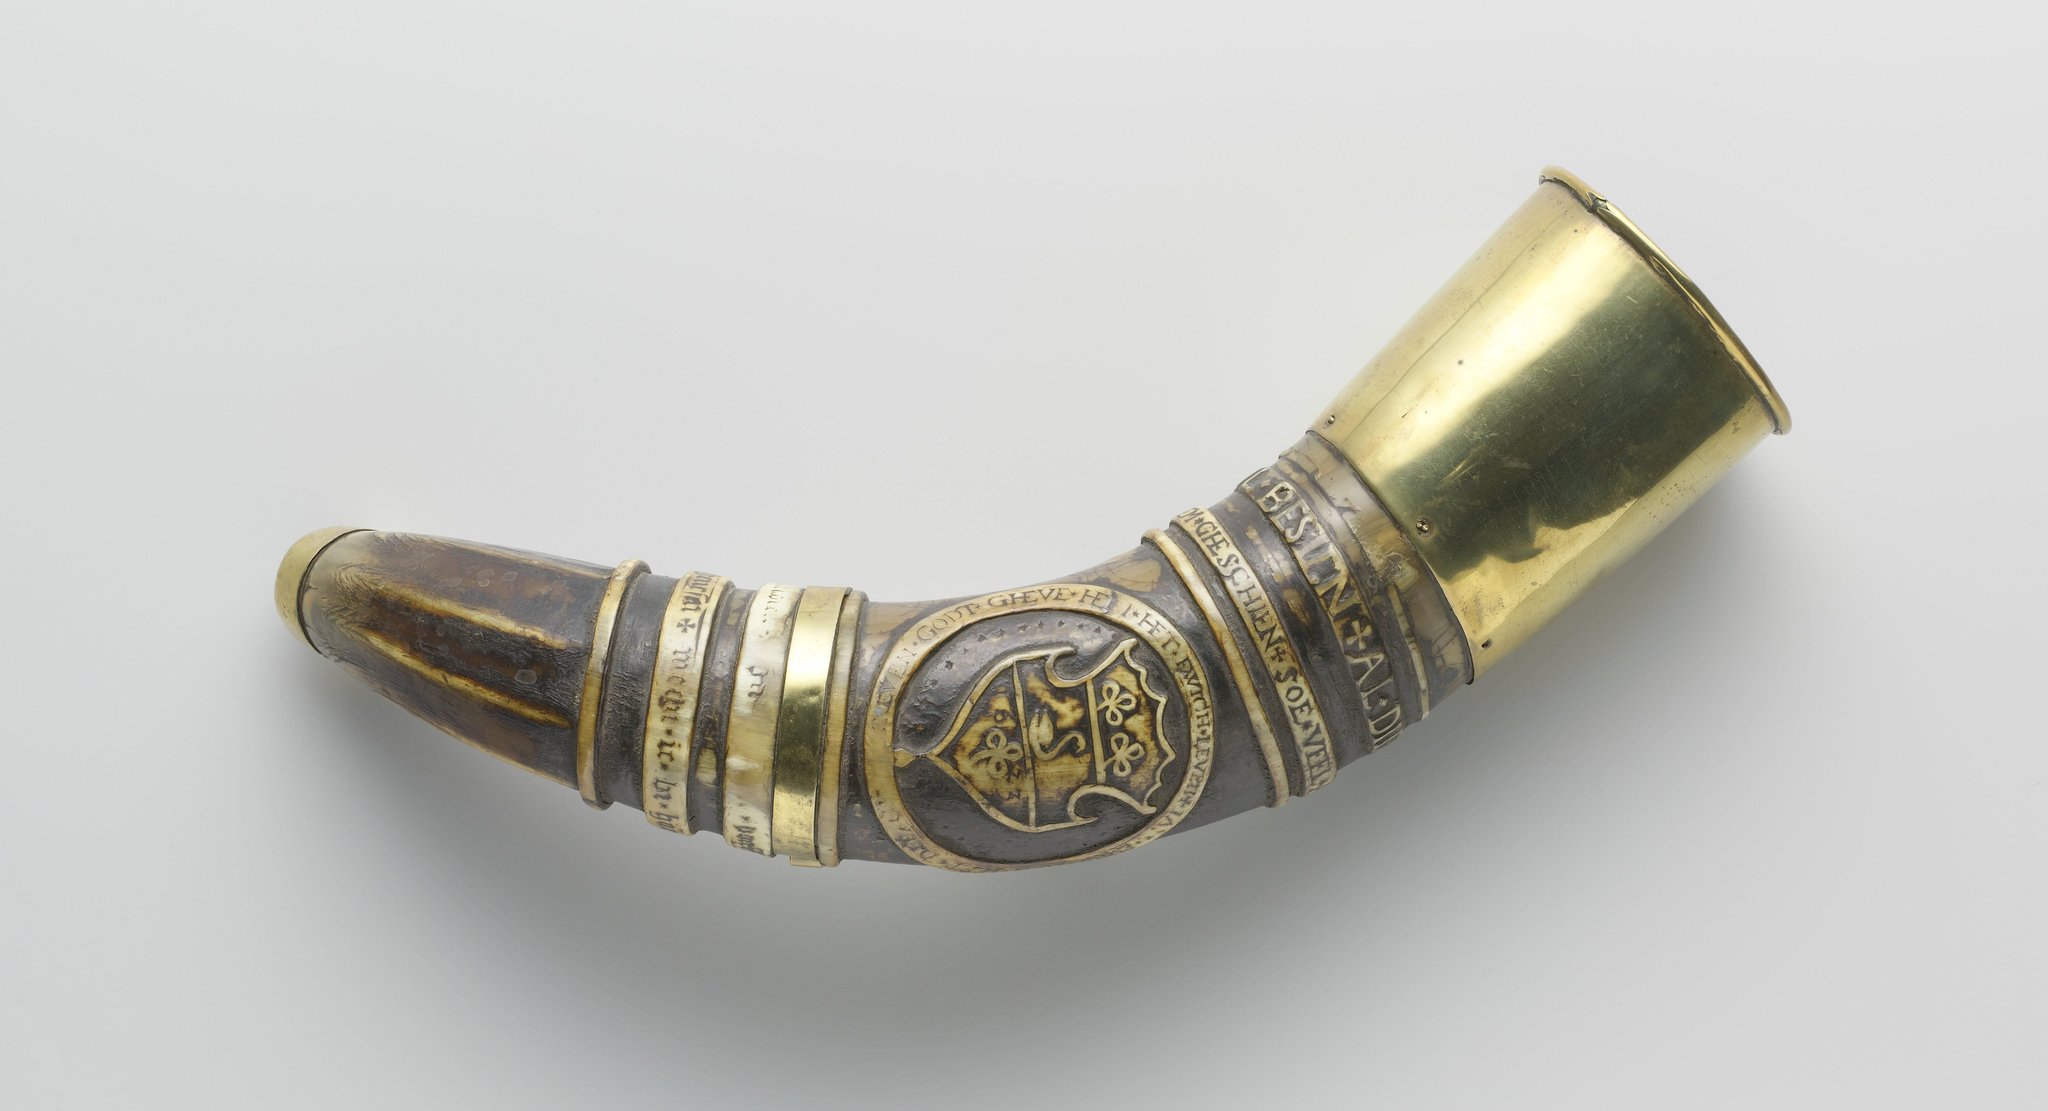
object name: horn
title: Ossenhoorn met koperen beslag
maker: Anonymous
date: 1400-1950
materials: copper, horn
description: Ossenhoorn met koperen beslag. Op het midden van de hoorn een wapen, waarin het jaartal 1623 en een omschrift EVERZOEN HEET DIT...MOEDT HEM GESCHIEN. Op twee dergelijke banden onder het wapen een opschrift.